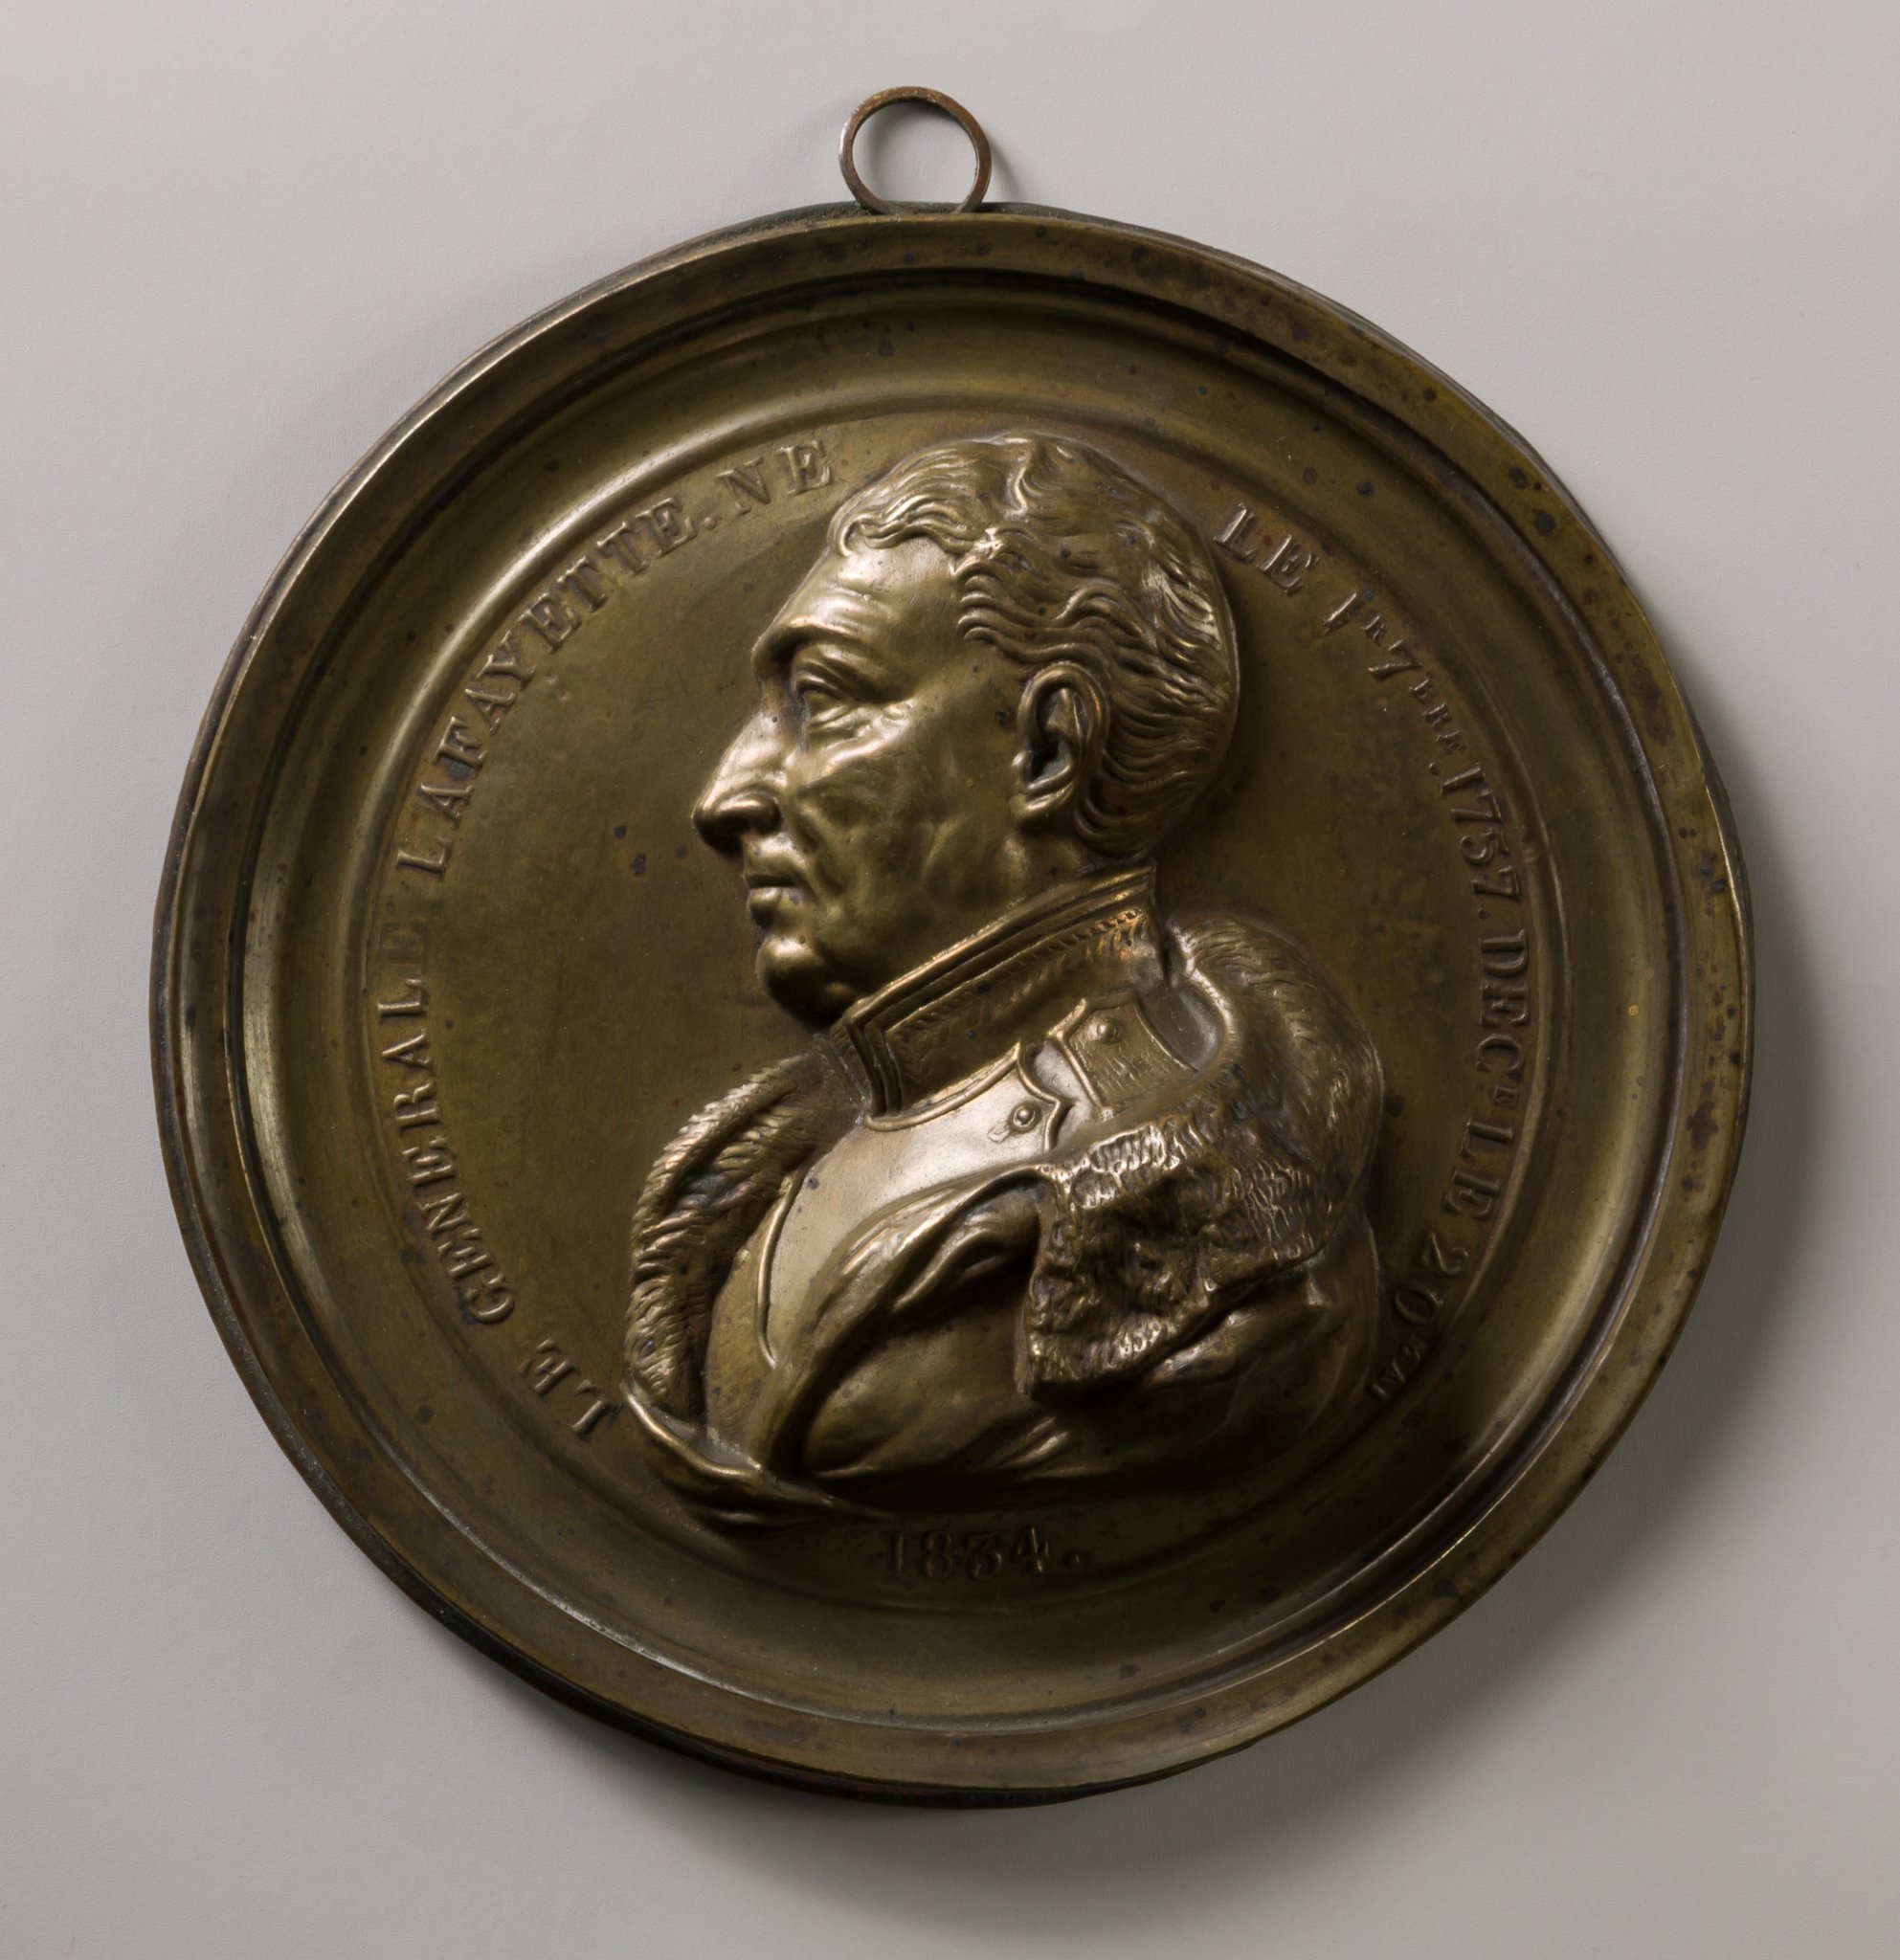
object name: medallion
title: Medallion of the Marquis de Lafayette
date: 1834-1883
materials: brass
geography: france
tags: men,portraits,profiles,marquis de lafayette